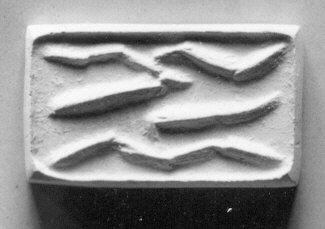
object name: stamp seal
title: Gable seal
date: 4000-3500 BCE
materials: stone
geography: northern syria or southeastern anatolia